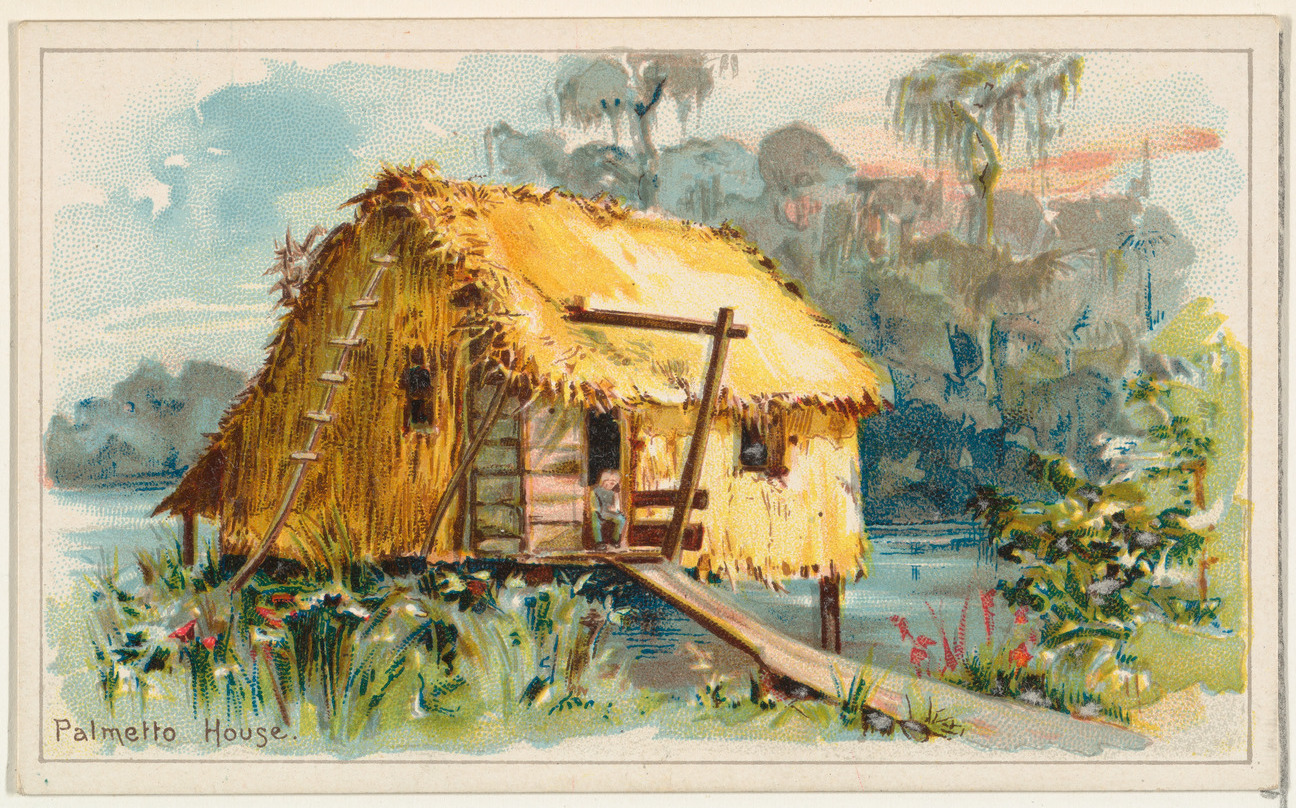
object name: print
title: Palmetto House, from the Habitations of Man series (N113) issued by W. Duke, Sons & Co. to promote Honest Long Cut Smoking and Chewing Tobacco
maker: the giles company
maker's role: artist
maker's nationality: american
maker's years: 1800-1900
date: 1890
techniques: color lithograph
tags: houses